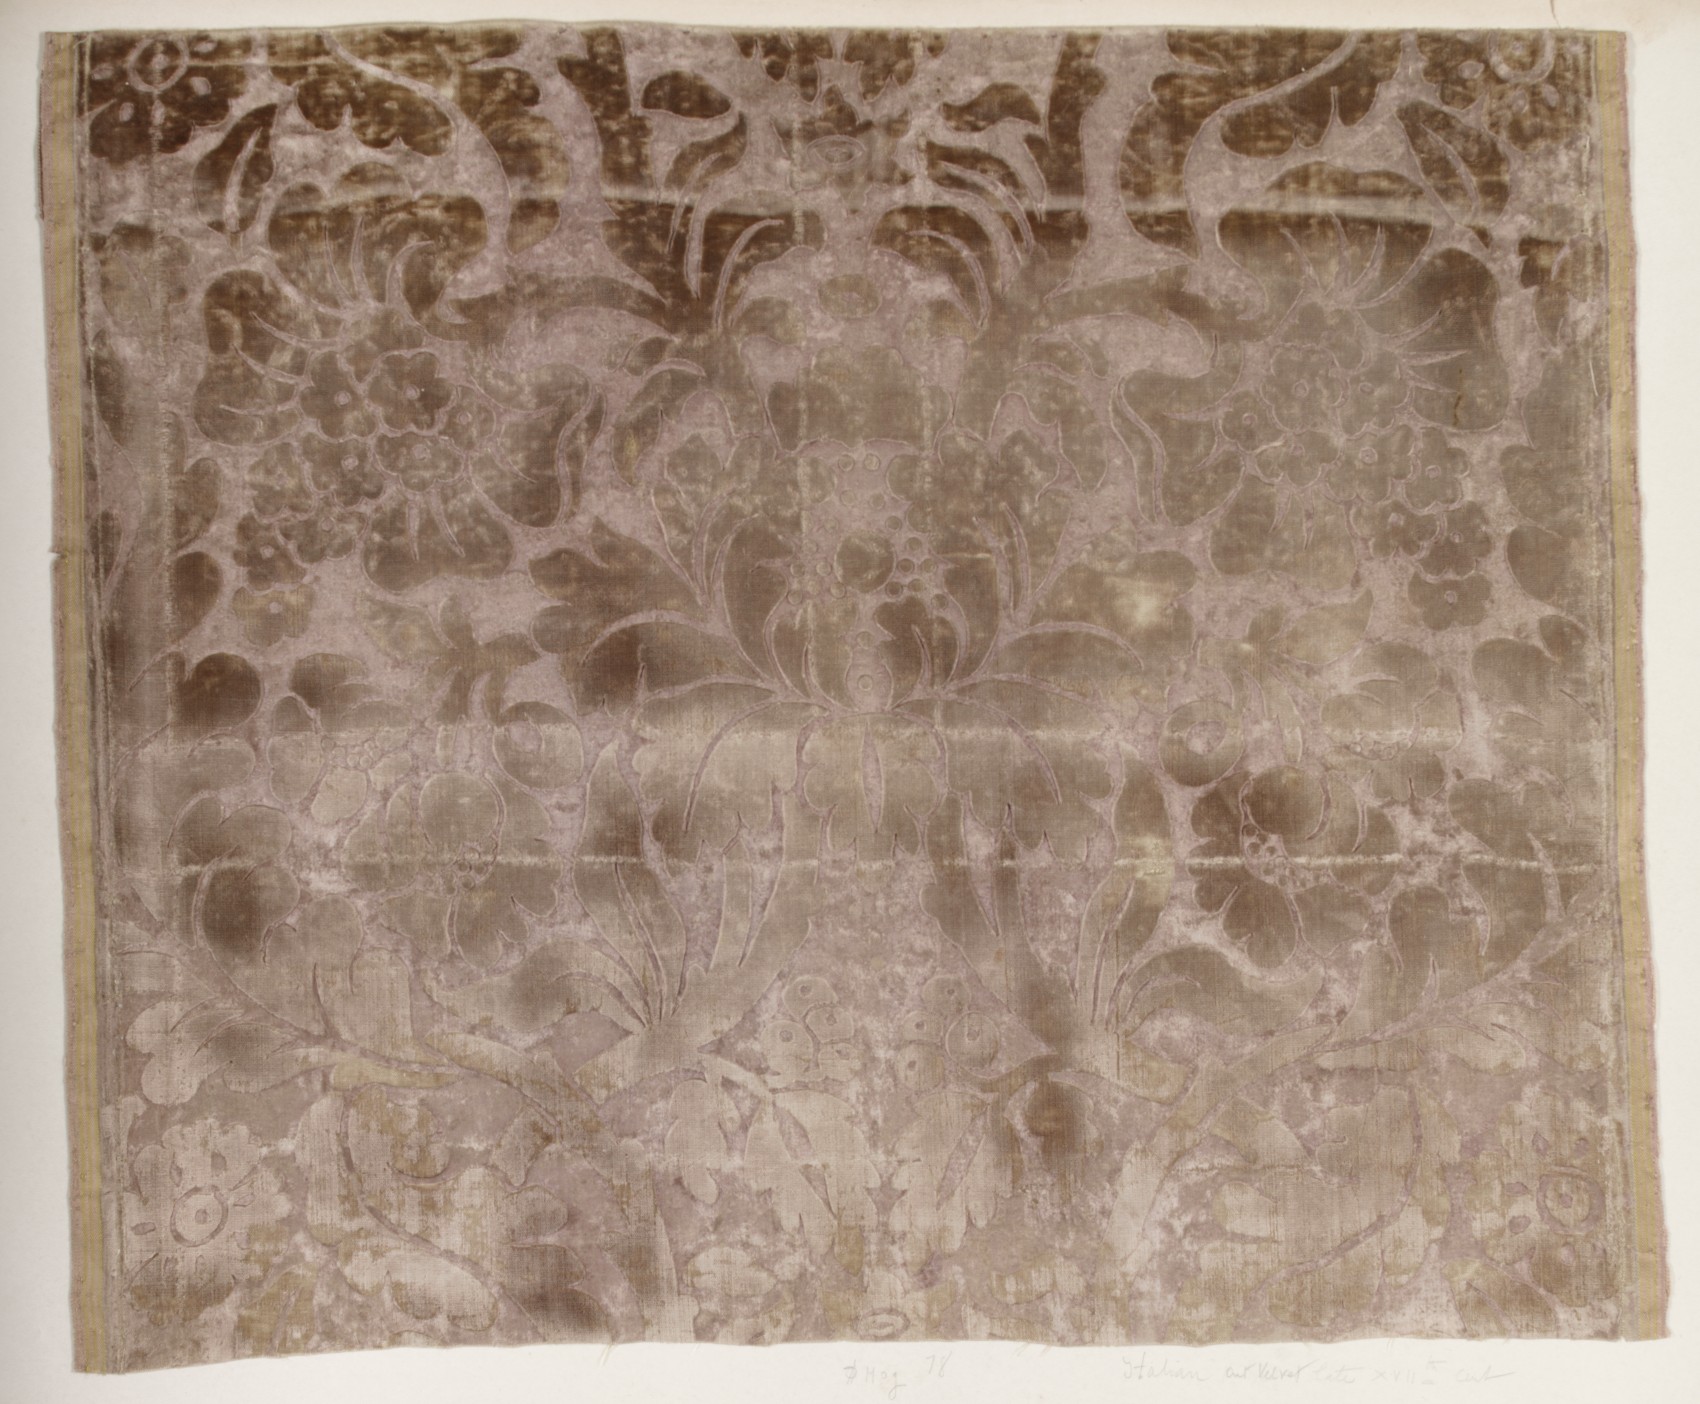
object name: fragment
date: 1601-1700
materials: silk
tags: flowers,leaves